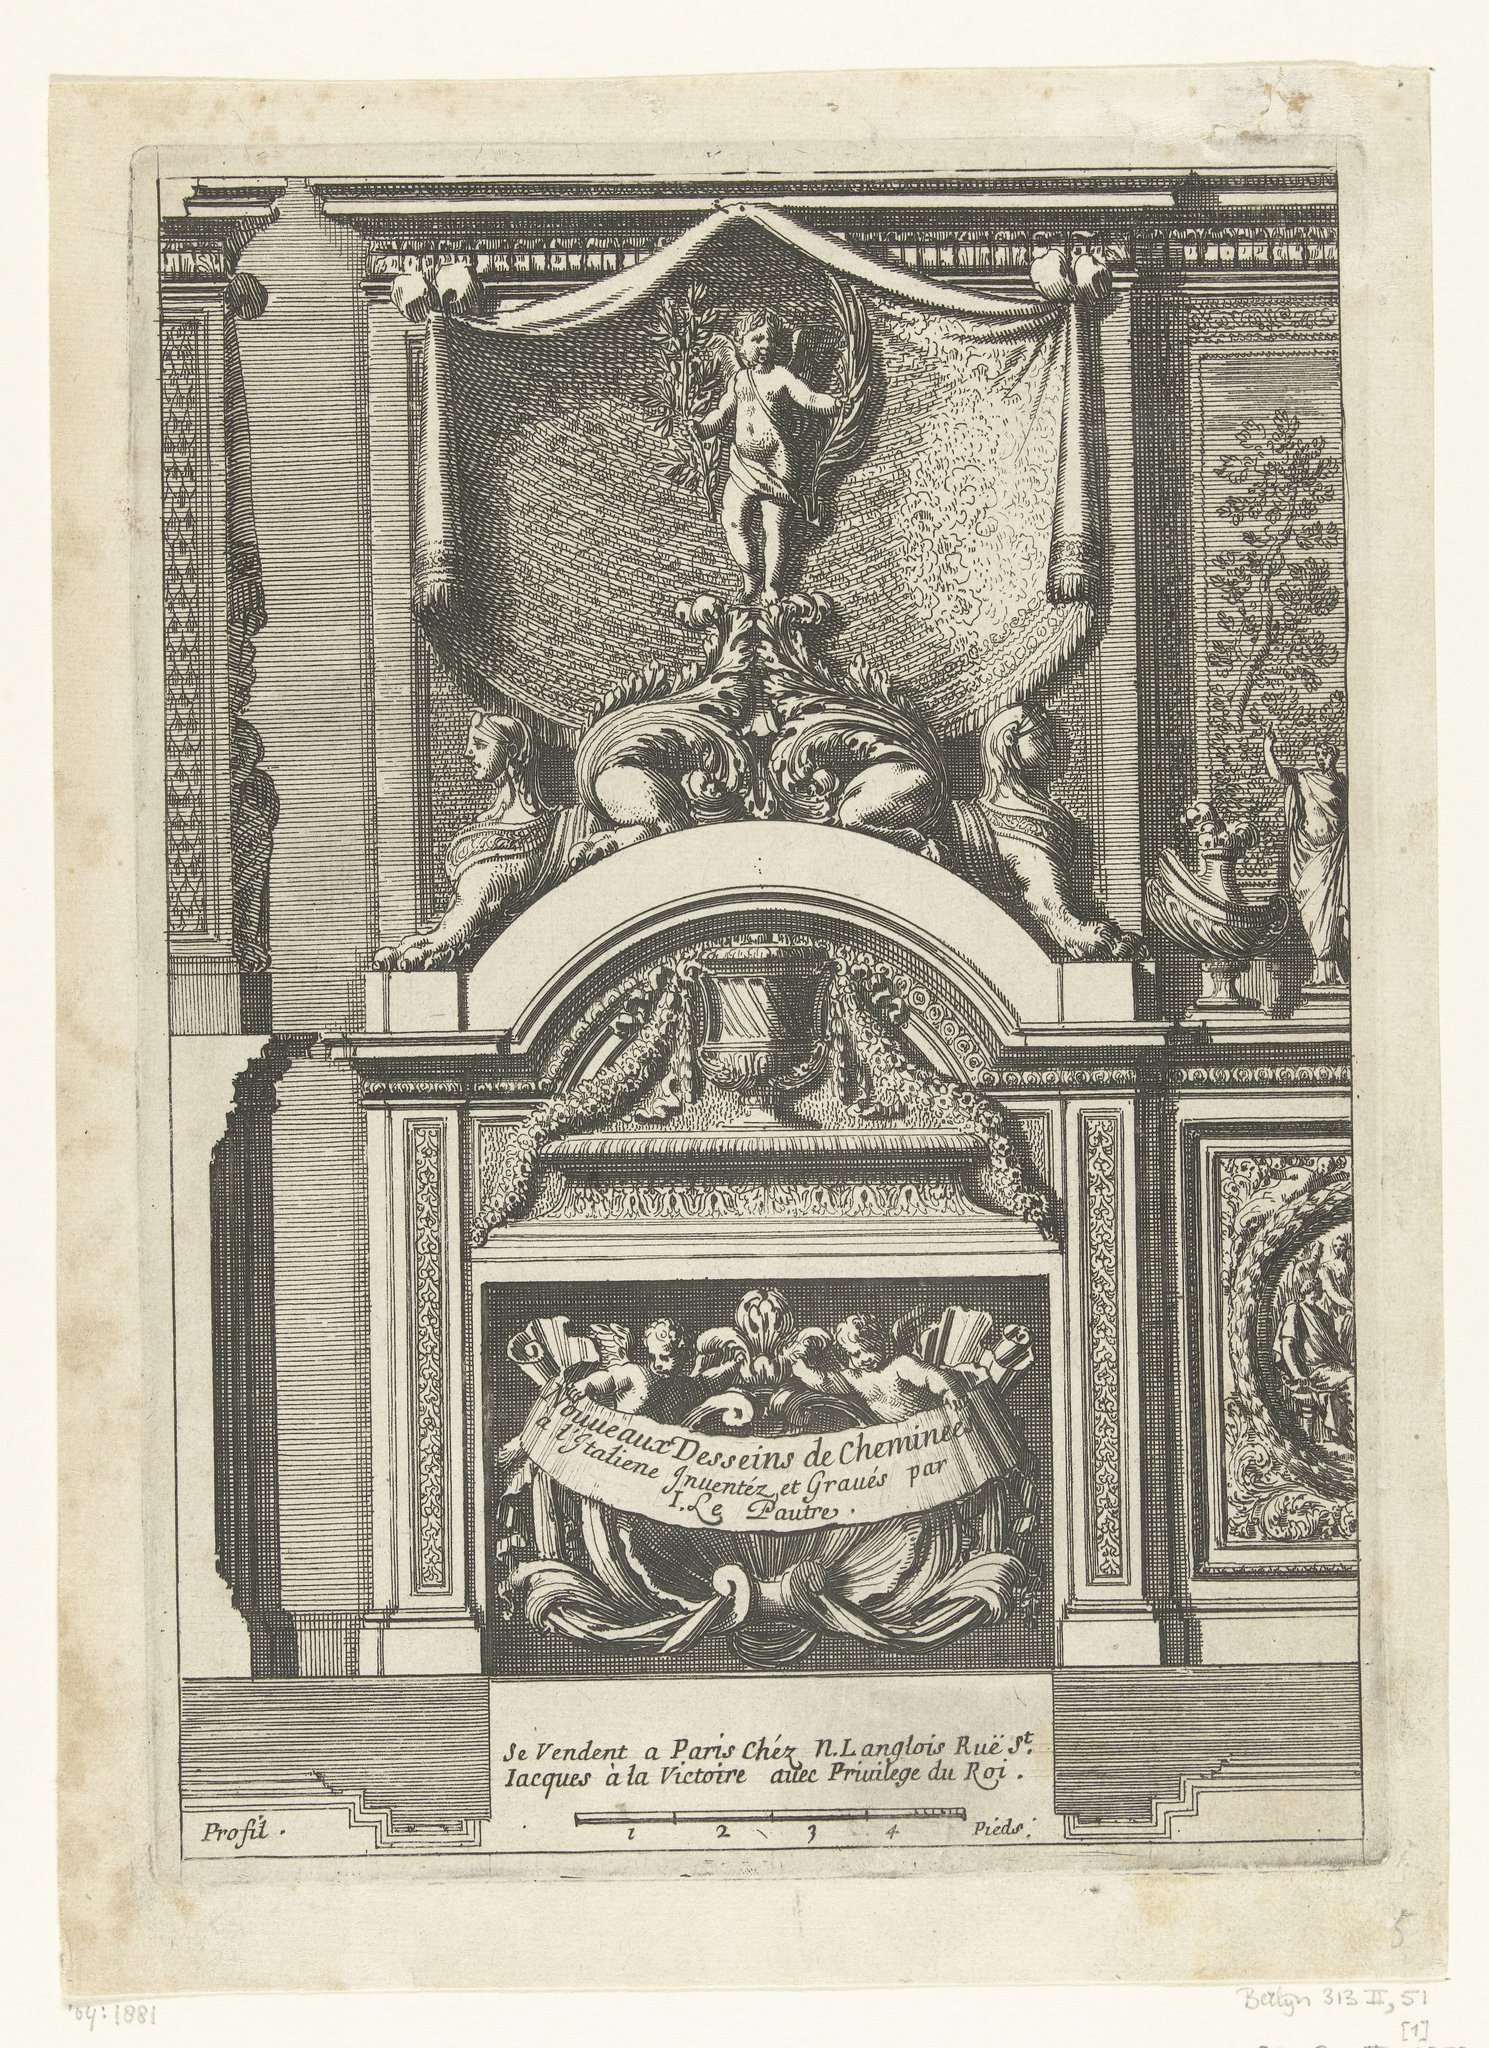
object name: ornament print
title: Nouueaux Desseins de Cheminees a l'Italiene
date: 1665-1670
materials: paper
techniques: etching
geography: france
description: Onderboezem bekroond met cupido die een palmtak en een olijftak vasthoudt. Opstand met profiel en plan, met schaal in Franse voet. Blad 1 uit serie van 6.